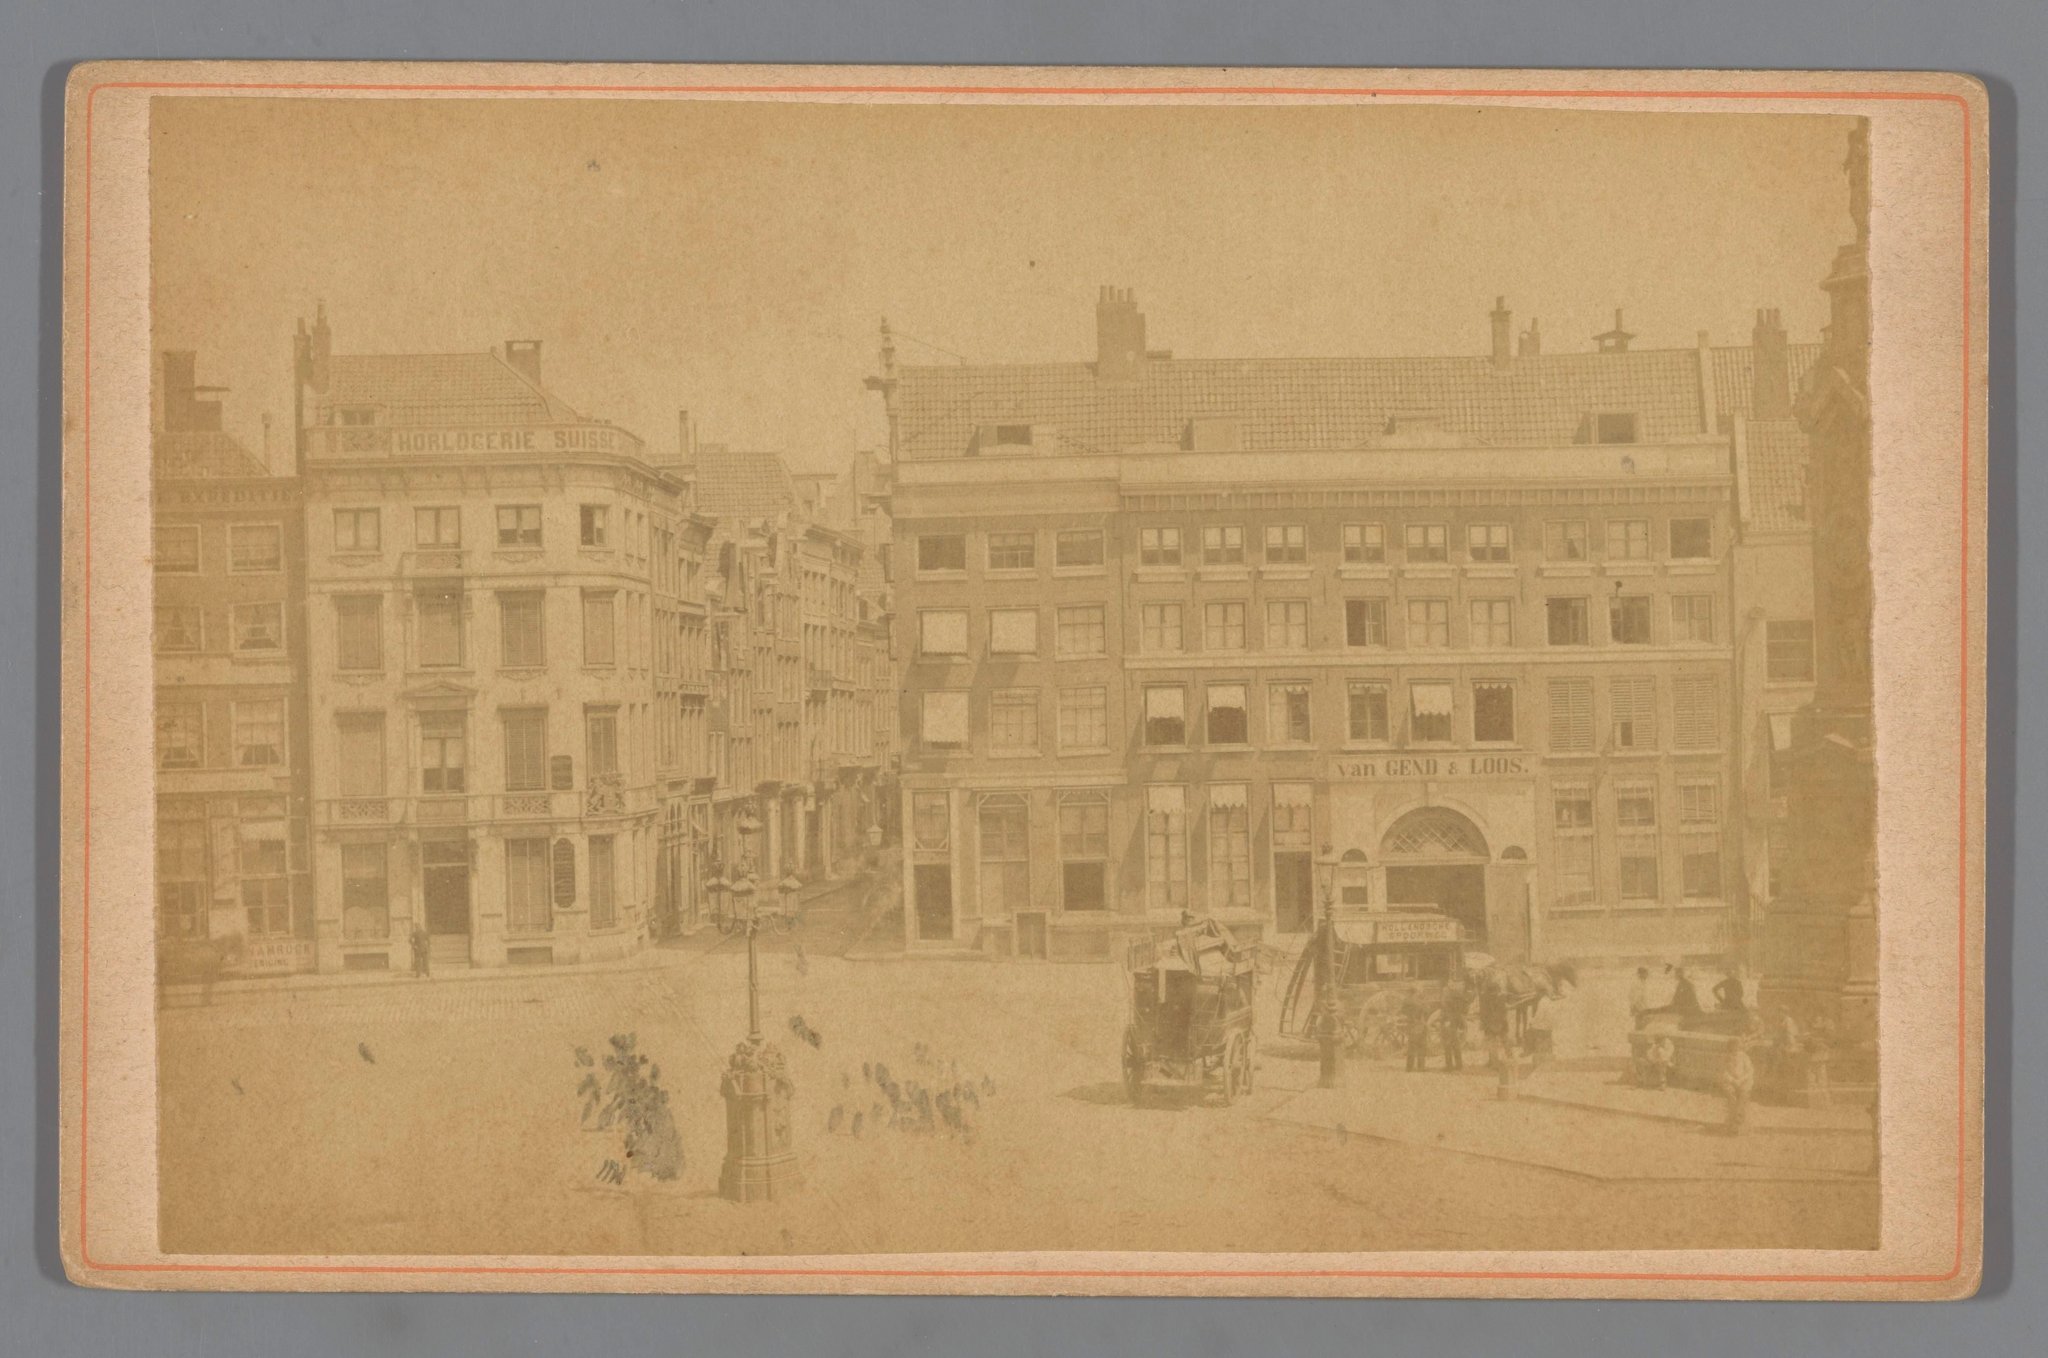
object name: cabinet photograph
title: Gezicht op het pand van Van Gend & Loos op de Dam in Amsterdam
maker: Anonymous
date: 1850-1900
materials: cardboard, photographic support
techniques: albumen print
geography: amsterdam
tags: square, place, circus, etc.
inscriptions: annotation: ‘Dam + Nieuwendijk’